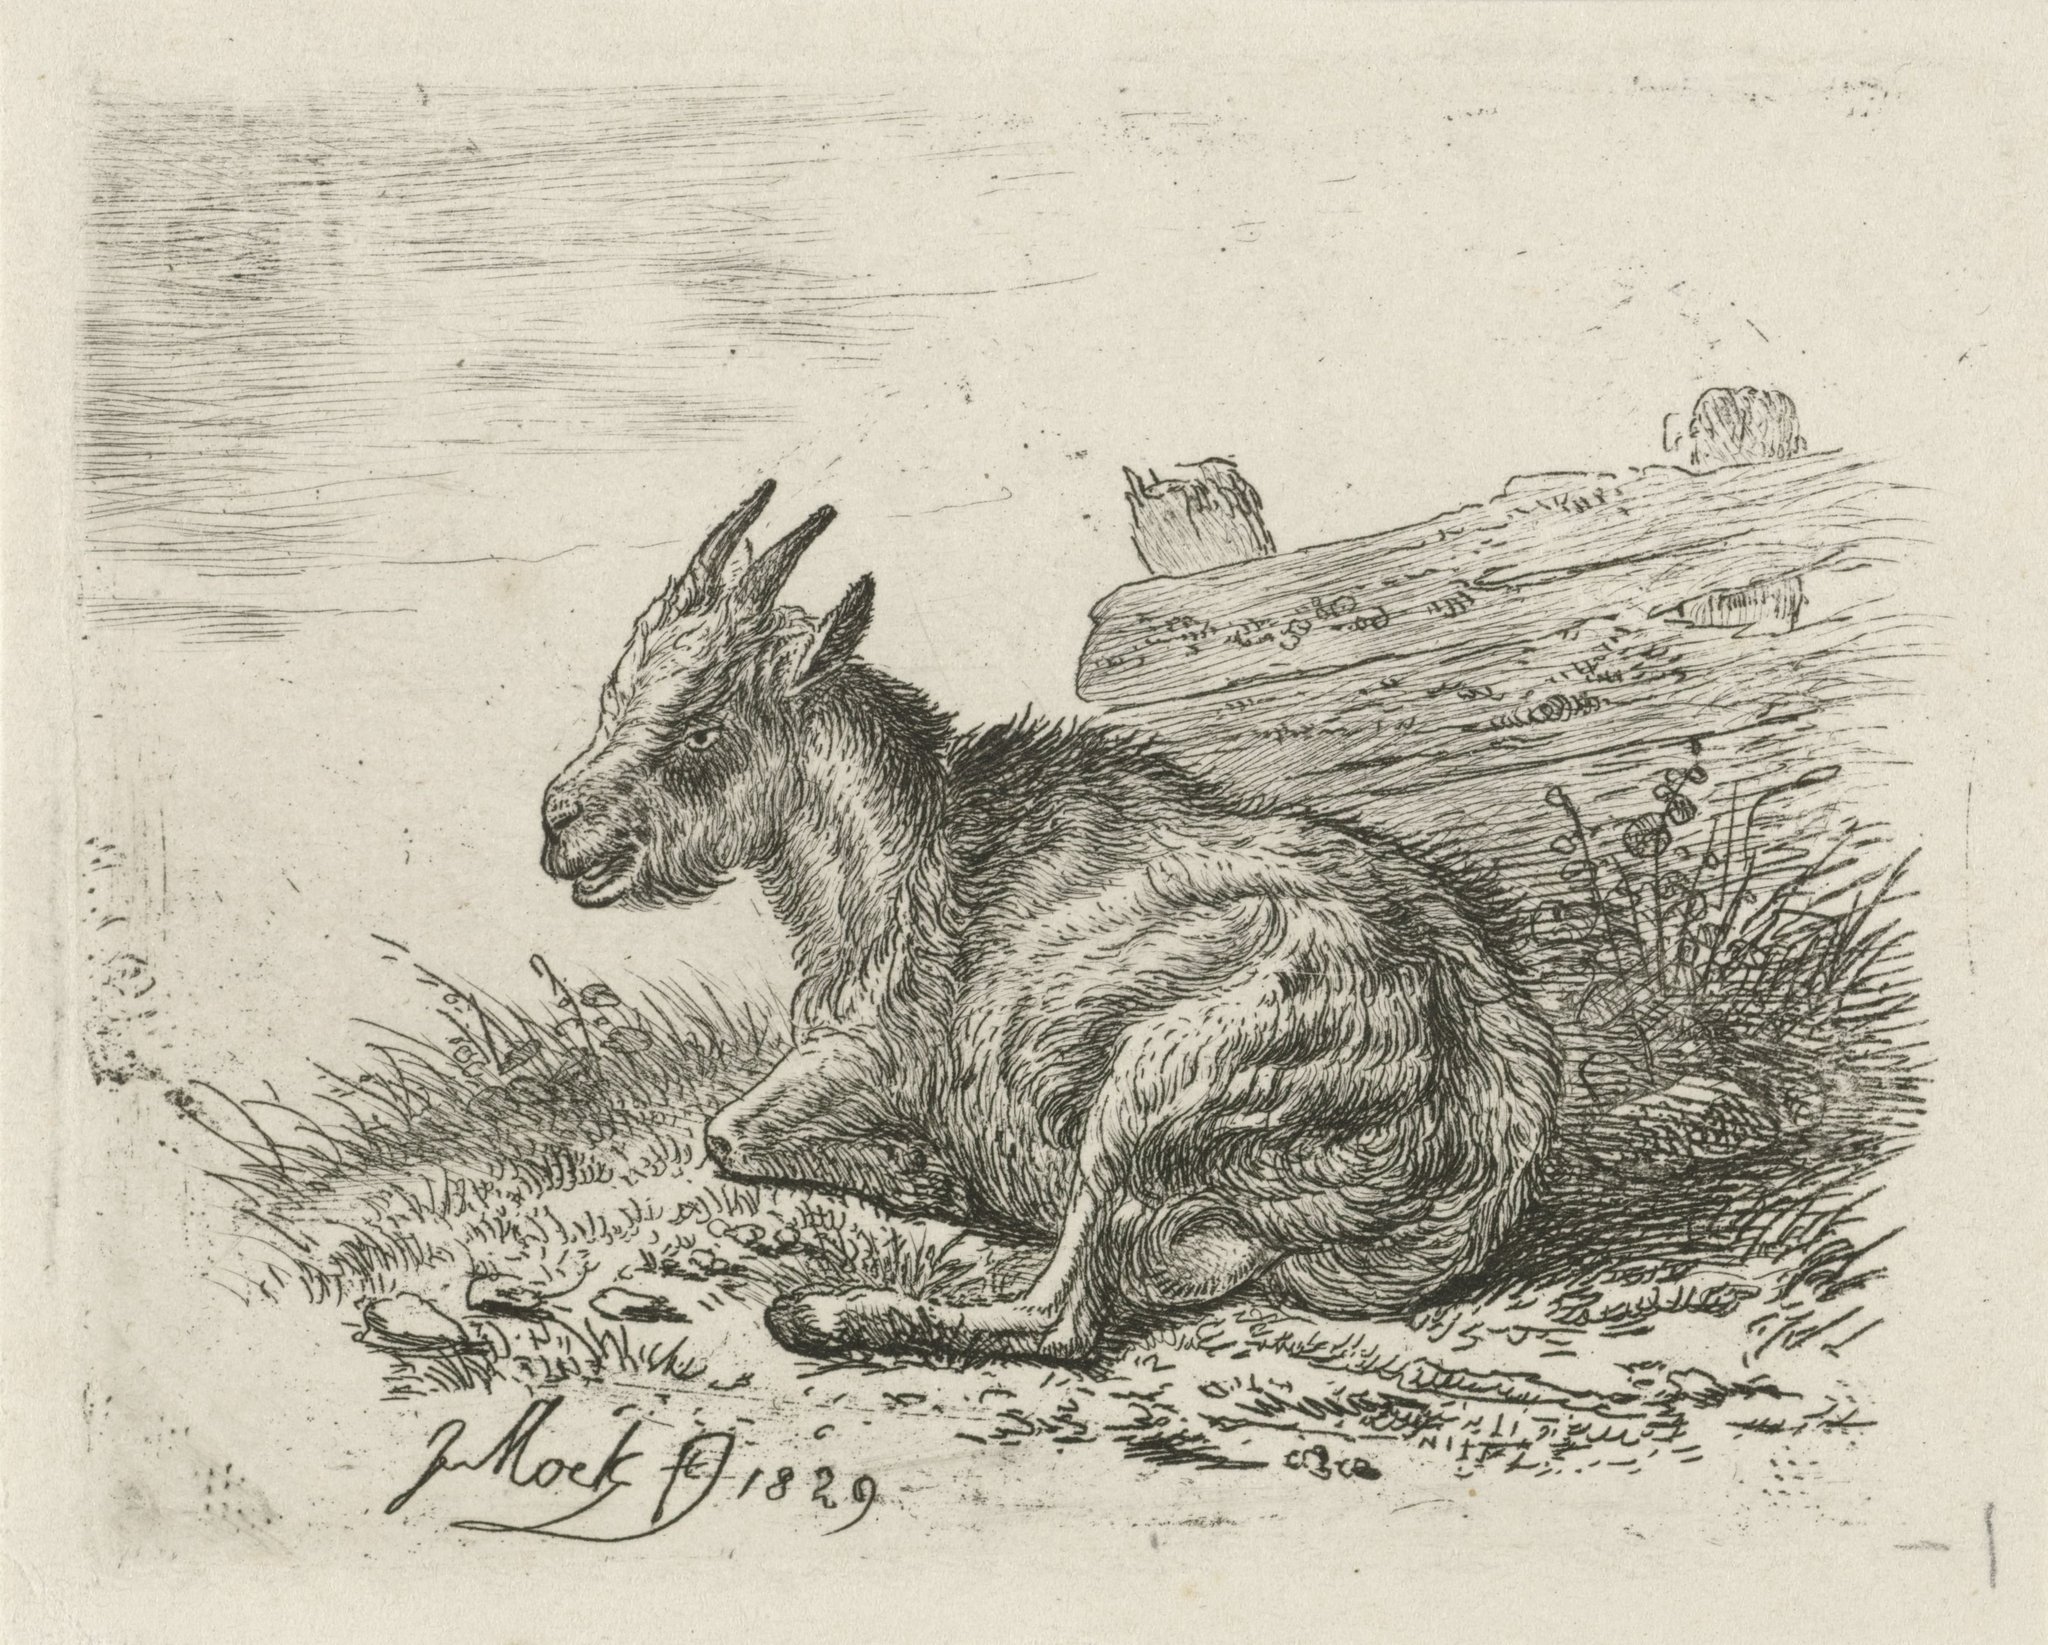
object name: print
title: Liggend bokje bij een hek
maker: johannes mock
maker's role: draughtsman, painter, print maker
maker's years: 1800-1884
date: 1829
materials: paper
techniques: etching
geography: netherlands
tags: goat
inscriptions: collector's mark: Lugt 2228